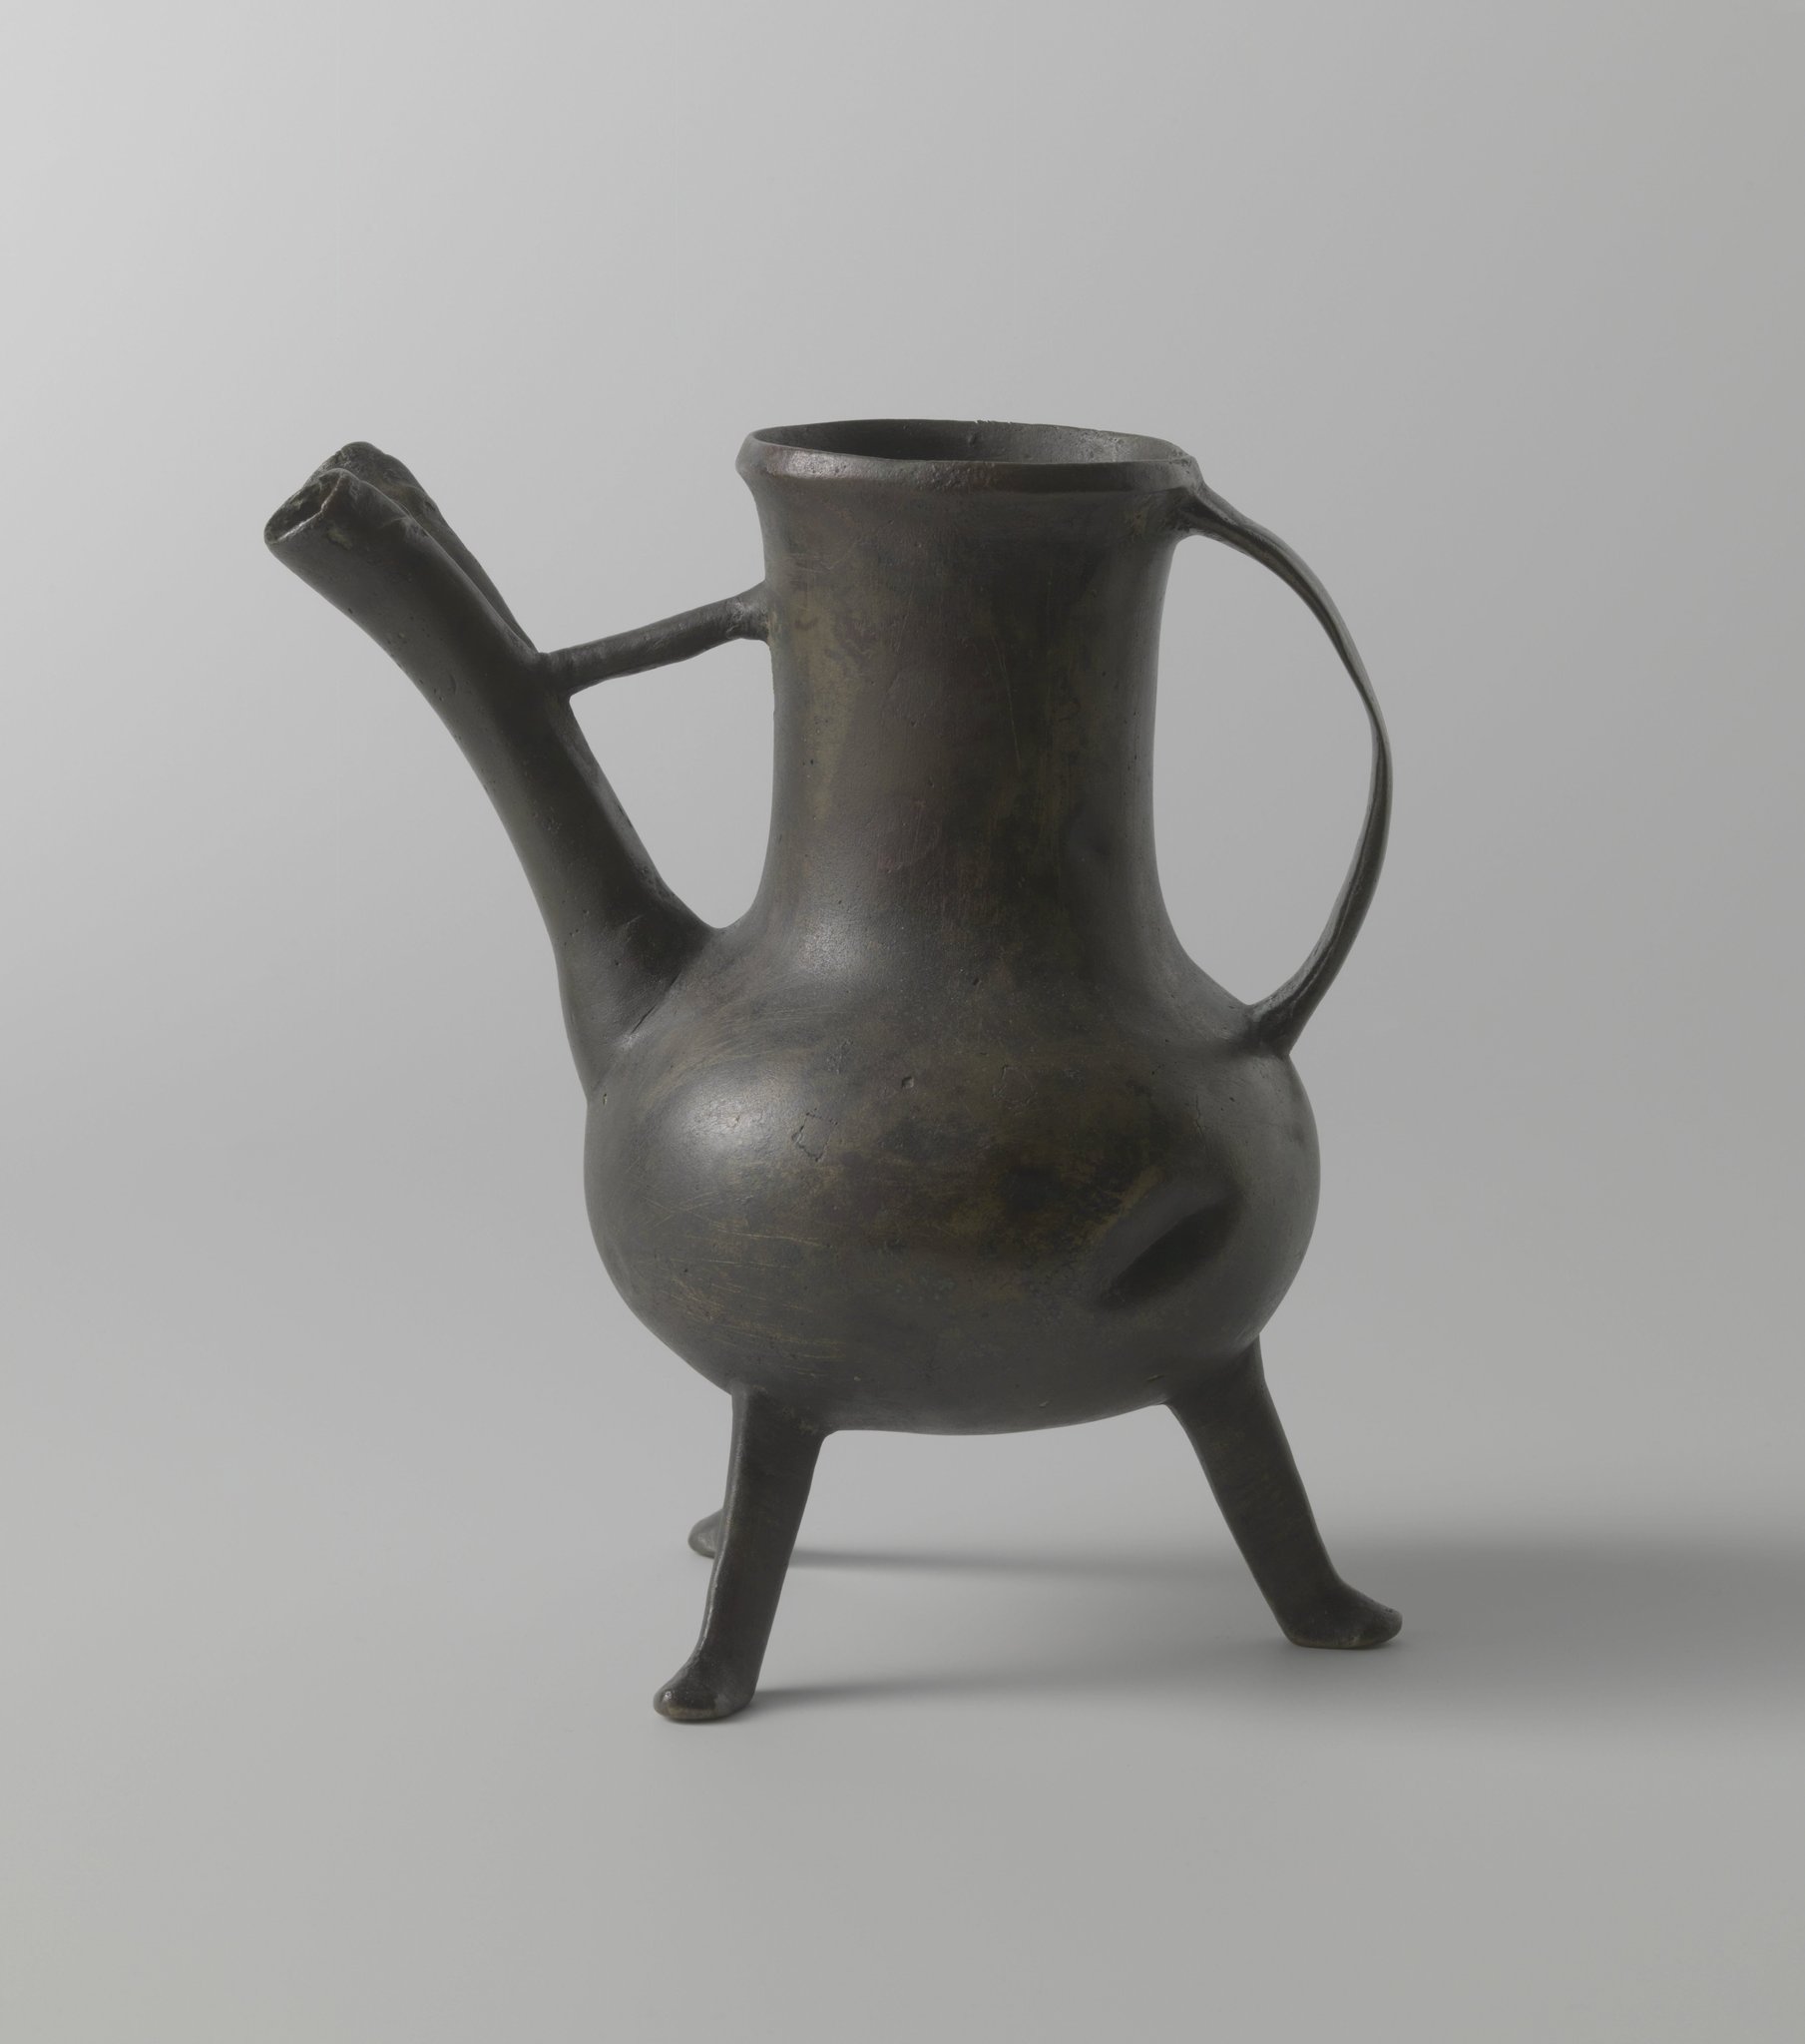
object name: ewer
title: Kan met tuit met twee mondingen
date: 1325-1350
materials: brass, copper alloy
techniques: casting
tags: haarlemmermeer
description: Jug. Bronze or brass. Netherlands, c. 1325 - 1350.